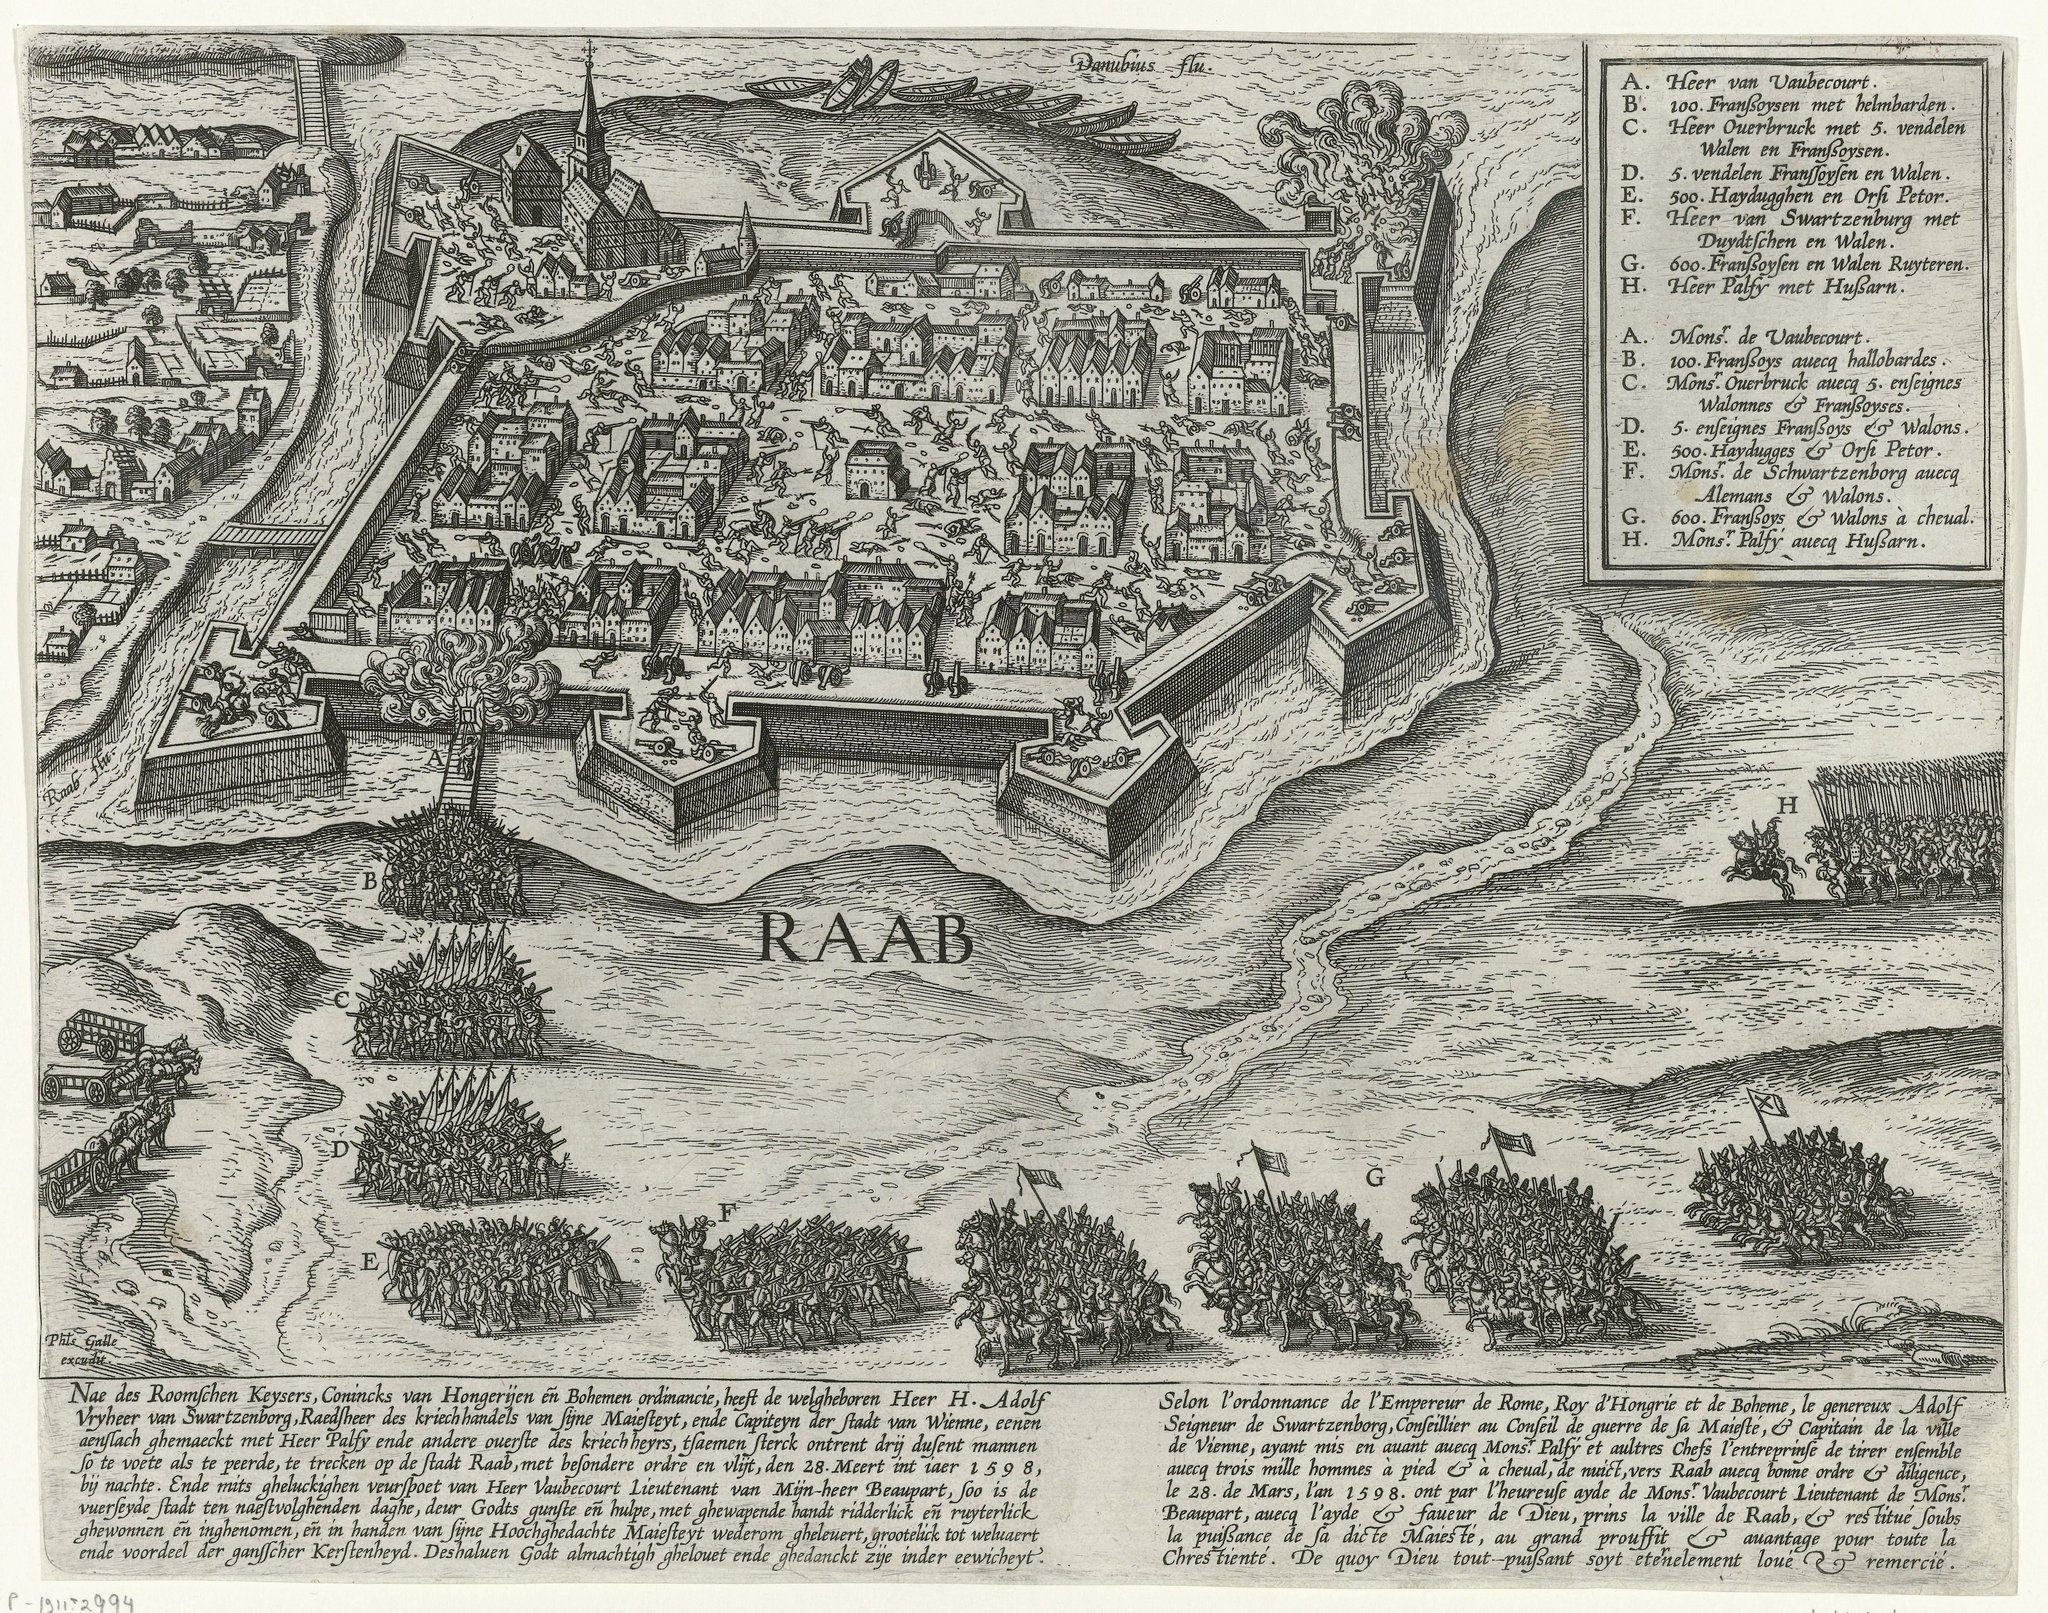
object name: print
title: Verovering van Raab, 1598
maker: philips galle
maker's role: print maker, publisher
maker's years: 1537-1612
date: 1598-1612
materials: paper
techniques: etching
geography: antwerp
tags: gyor, oorlog van turken tegen heilige roomse rijk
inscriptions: collector's mark: Lugt 2228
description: Verovering van Raab (Javarin of Gyor) in Hongarije aan de Donau door de Christenen op de Turken, 28 maart 1598. De prent heeft een legende met letters en een Nederlands en Frans onderschrift.